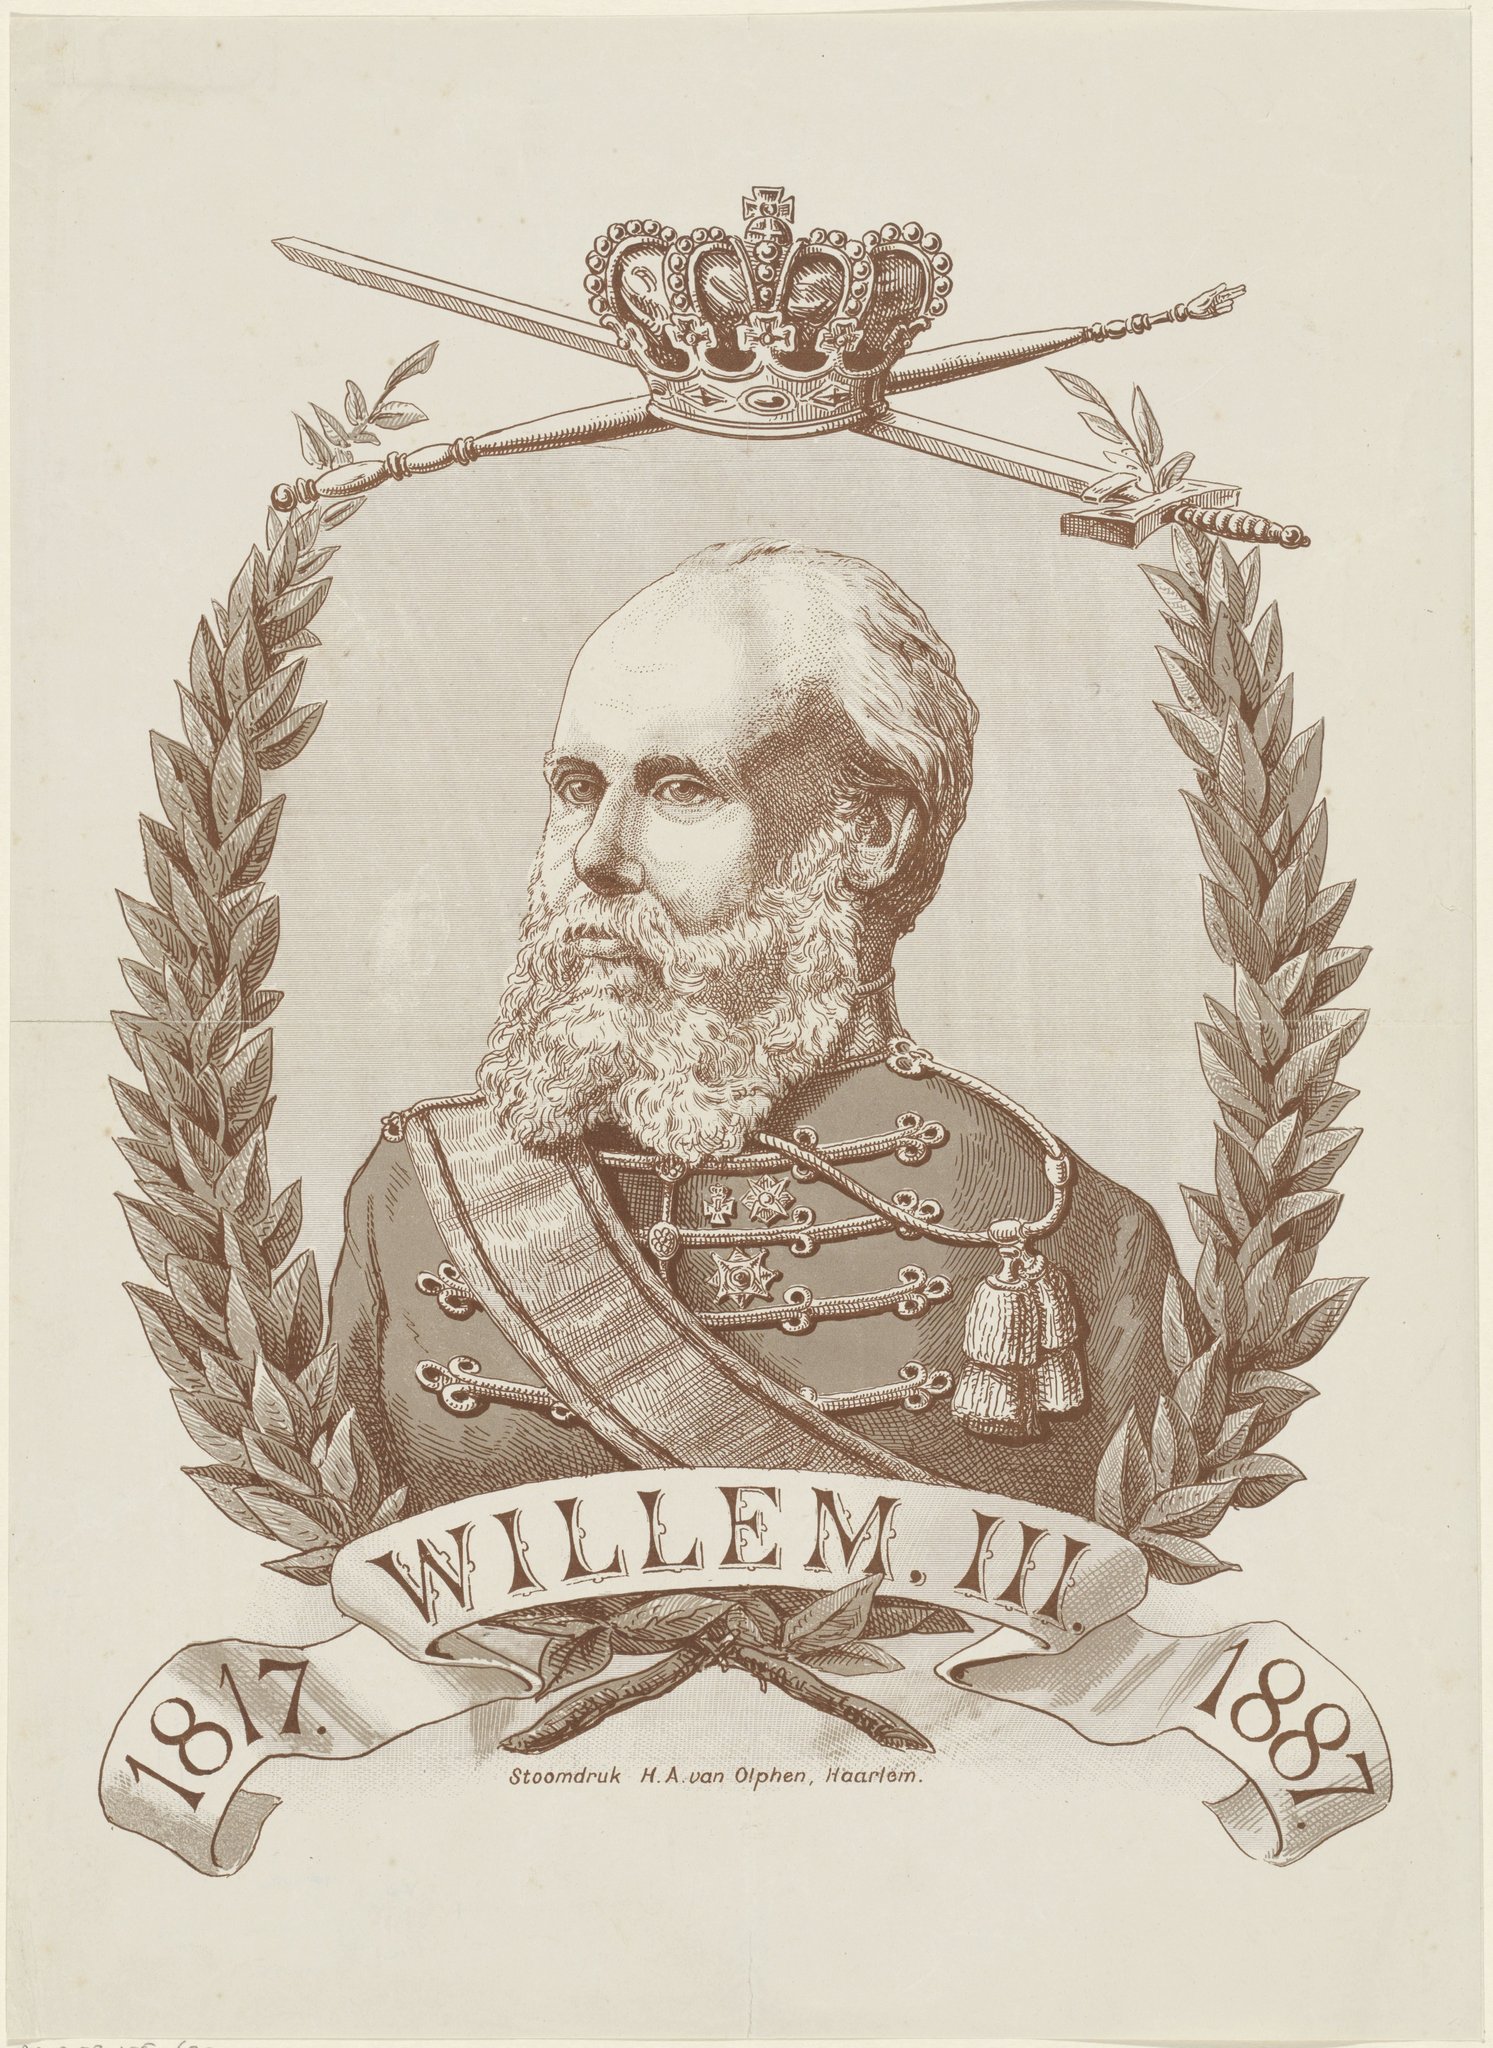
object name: print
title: Portret van Willem III, koning der Nederlanden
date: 1887-1889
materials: paper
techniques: lithograph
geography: netherlands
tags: willem iii (koning der nederlanden)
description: Portret van Willem III in een ovaal van lauwertakken. Midden boven een kroon. Op een banderol '1817. WILLEM. III. 1887.'. Vervaardigd ter gelegenheid van de viering van de zeventigste verjaardag van Willem III op 19 februari 1887.